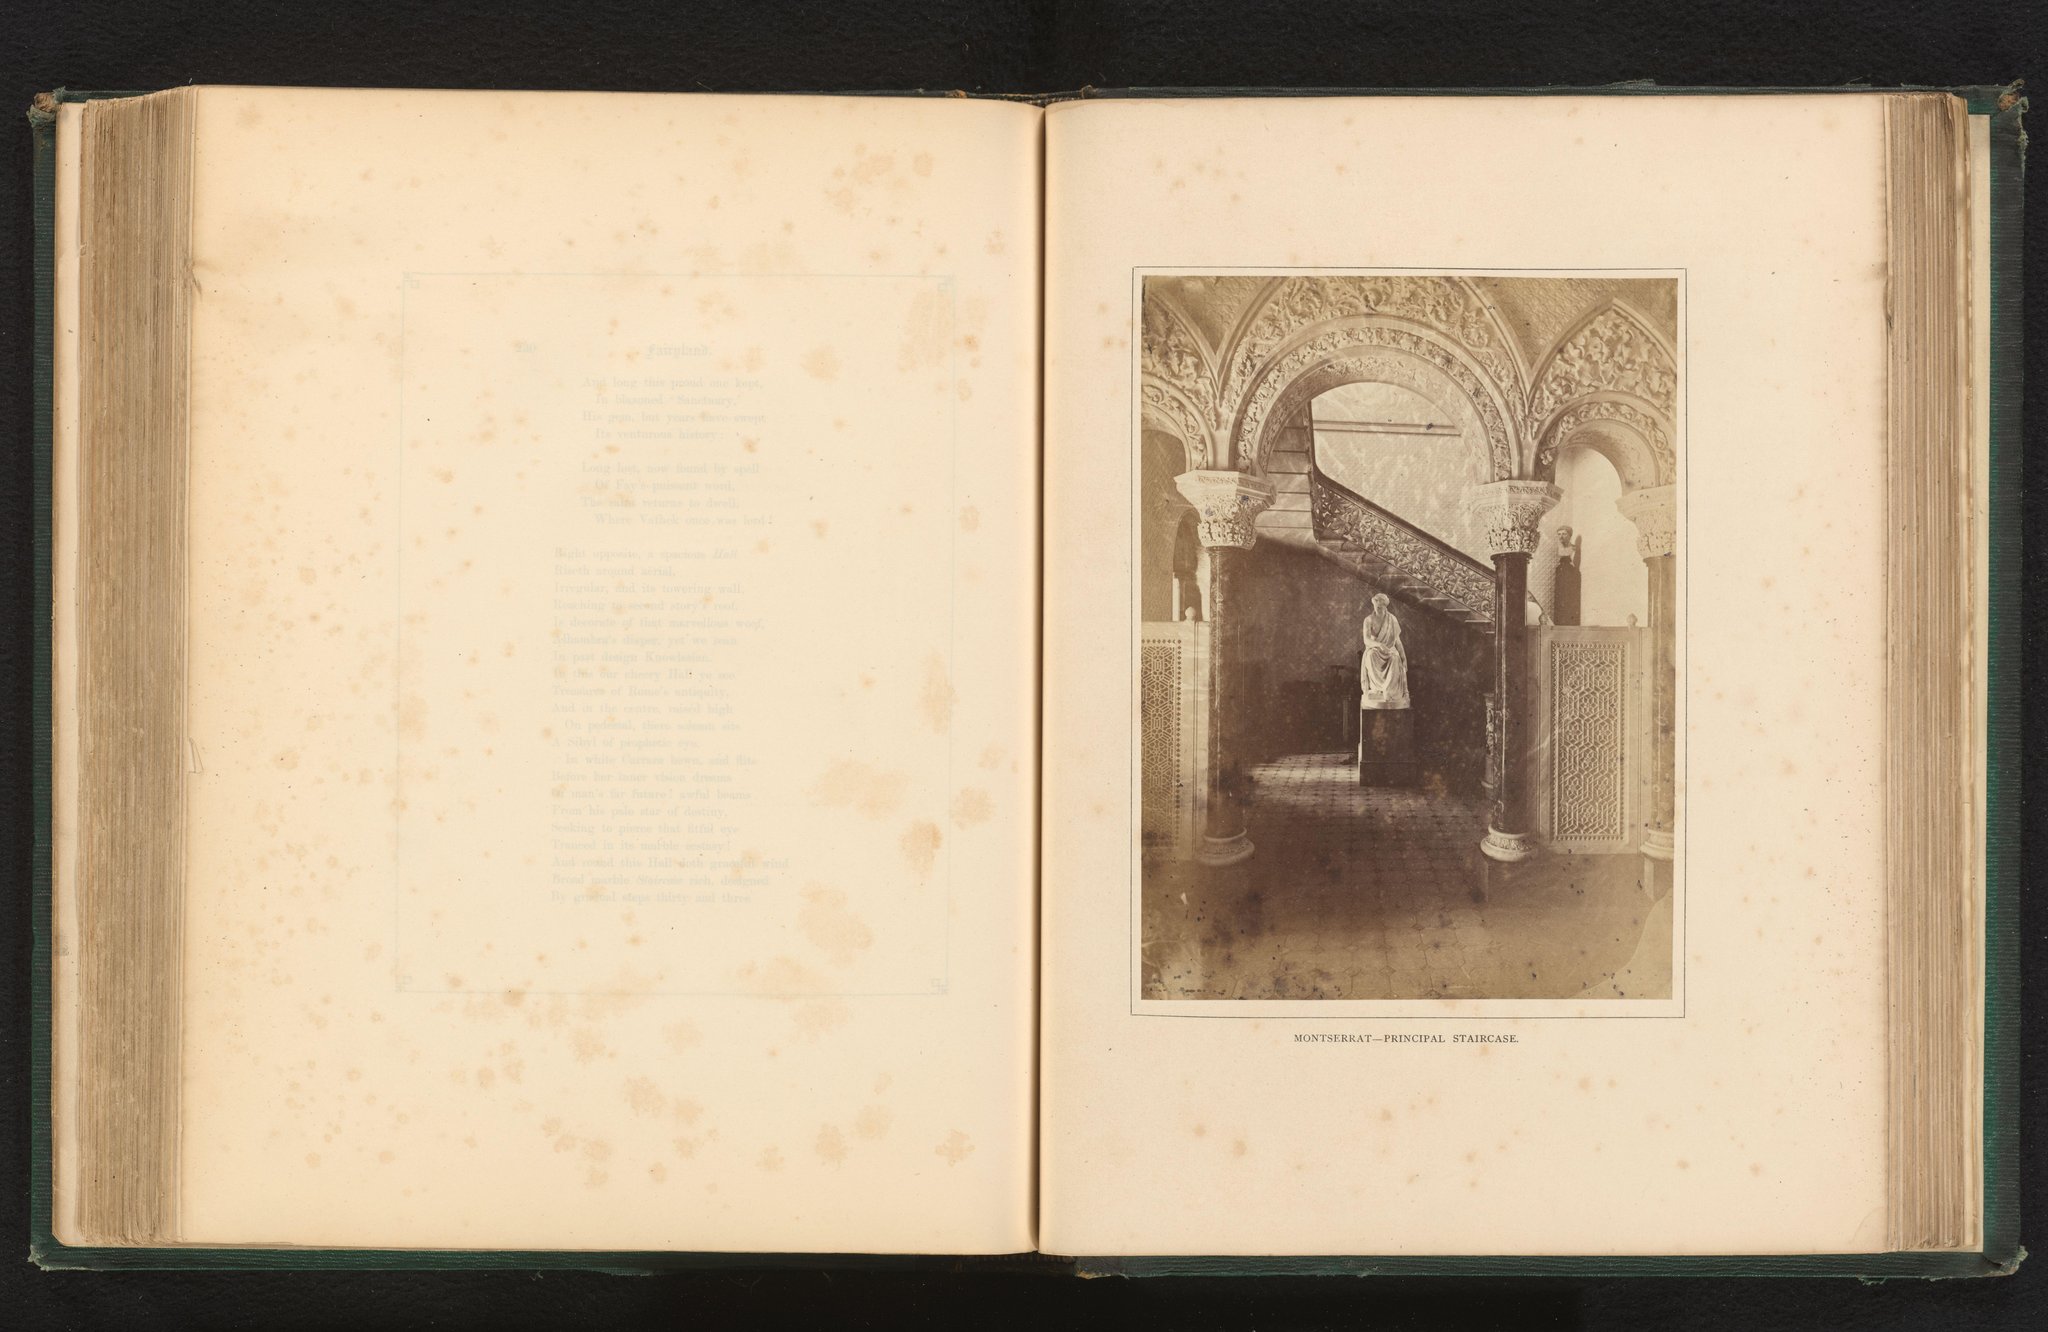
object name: page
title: Montserrat - Principal Staircase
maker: Anonymous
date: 1865-1870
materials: paper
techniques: albumen print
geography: sintra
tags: piece of sculpture, reproduction of a piece of sculpture, staircase